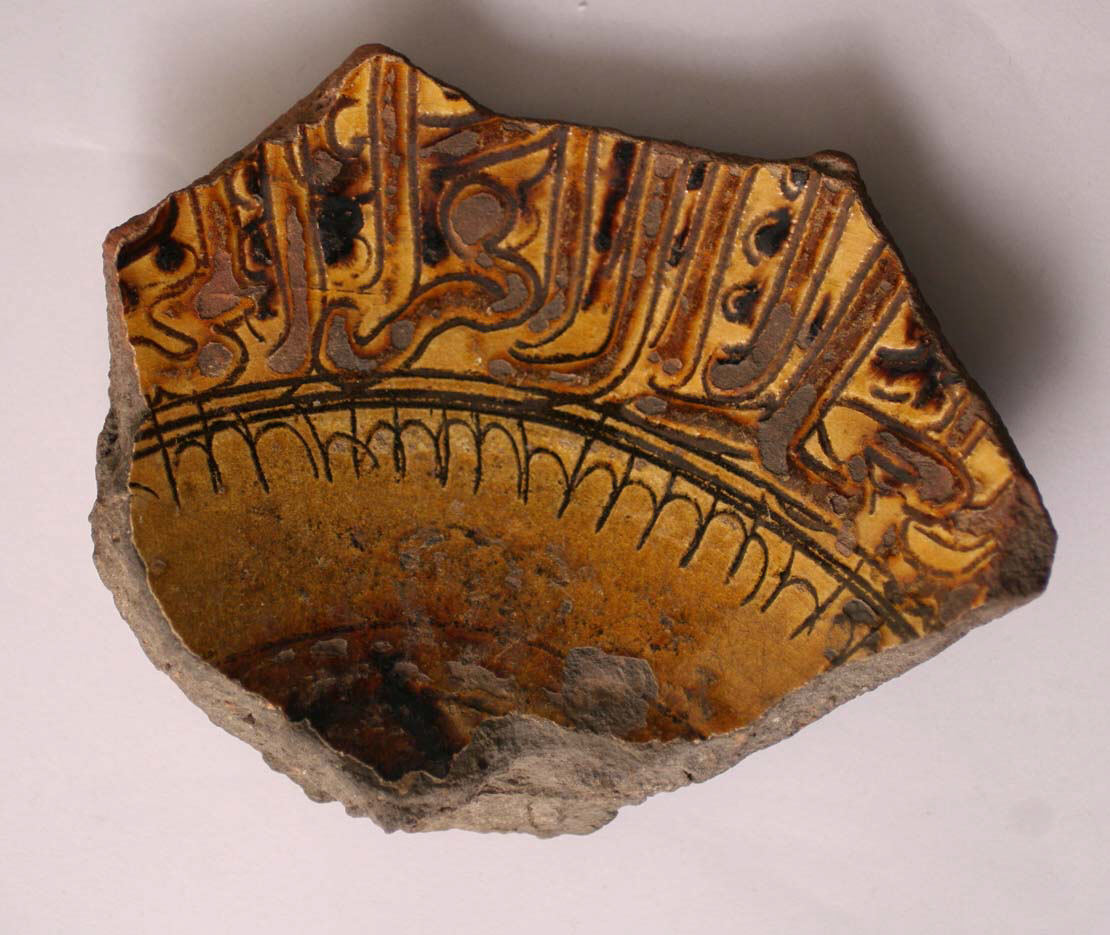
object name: fragment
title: Ceramic Fragment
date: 1301-1500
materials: earthenware, glaze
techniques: coloring, incising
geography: egypt